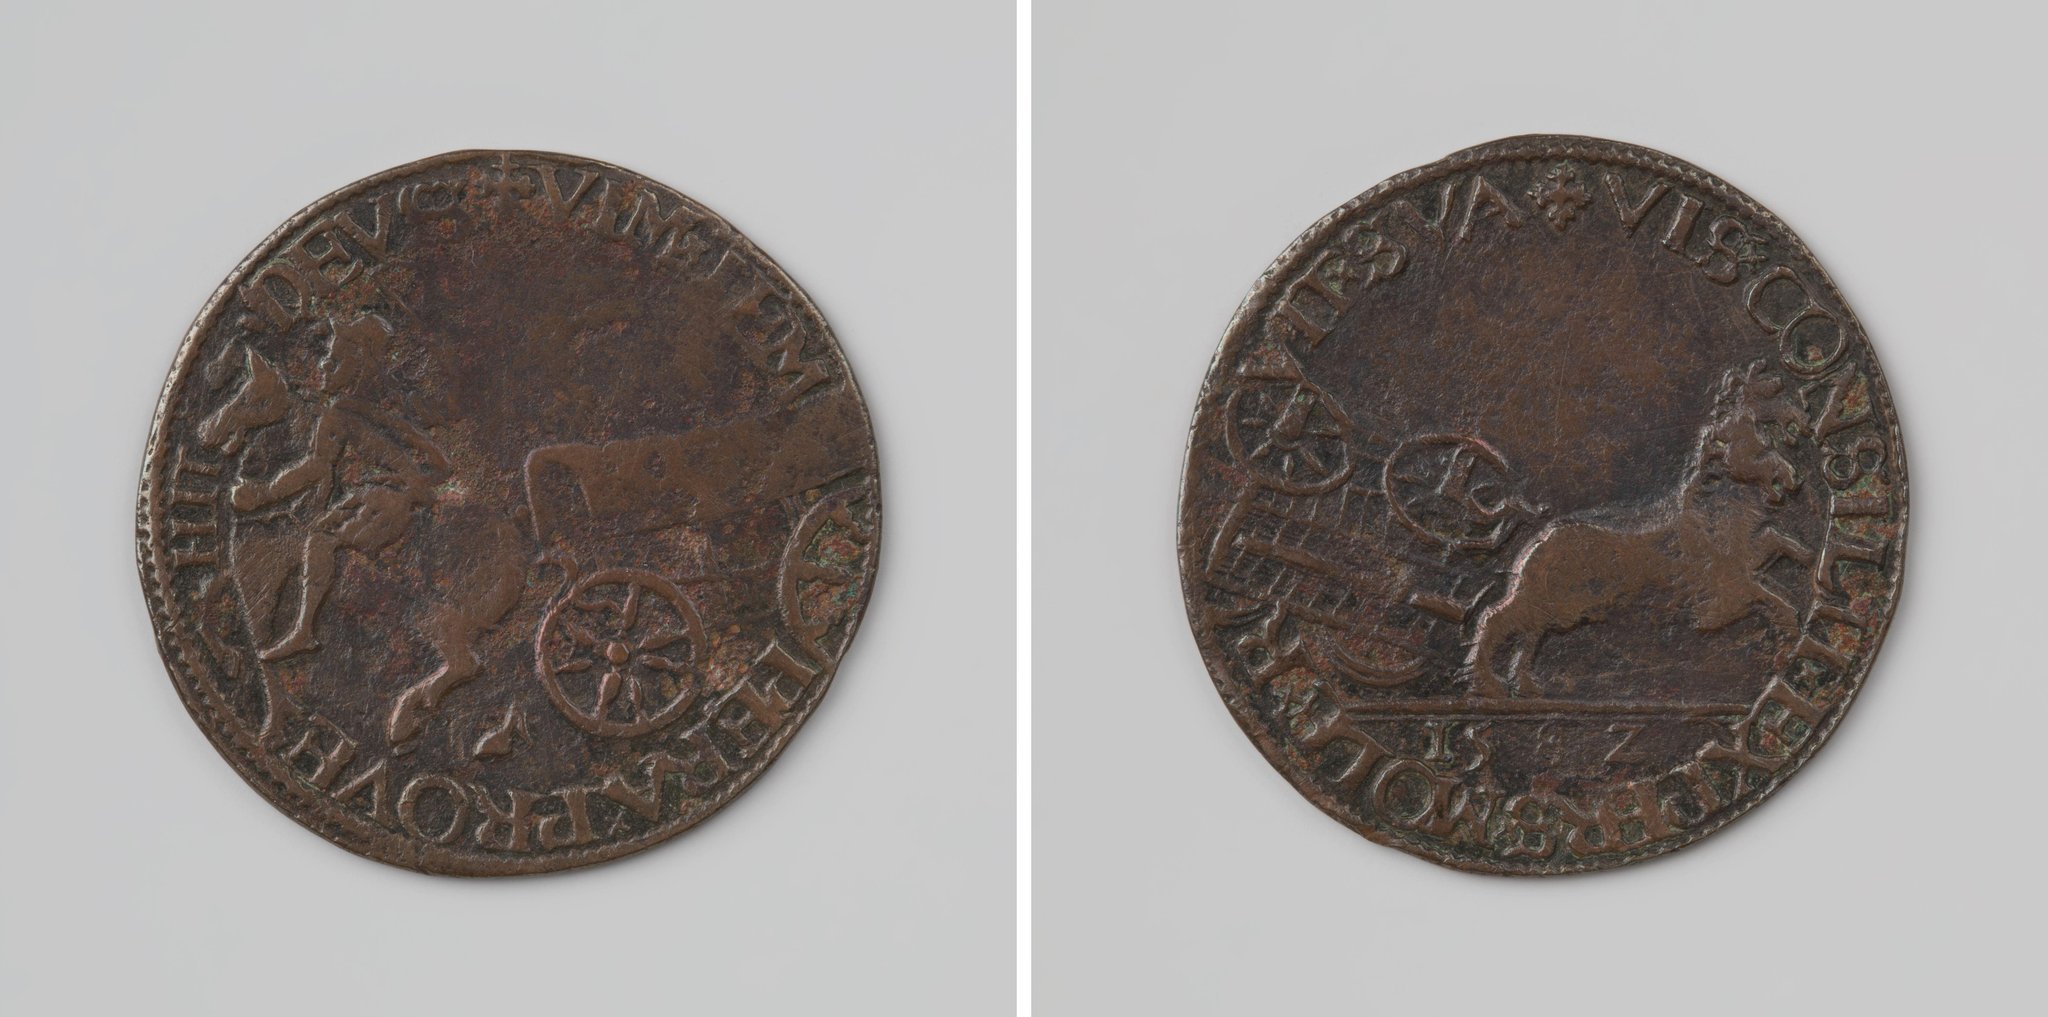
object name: jeton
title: Waarschuwing tegen de heerszucht van Francois-Hercule, hertog van Anjou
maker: Anonymous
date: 1582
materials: copper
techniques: striking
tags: paris, françois-hercule de valois (hertog van anjou)